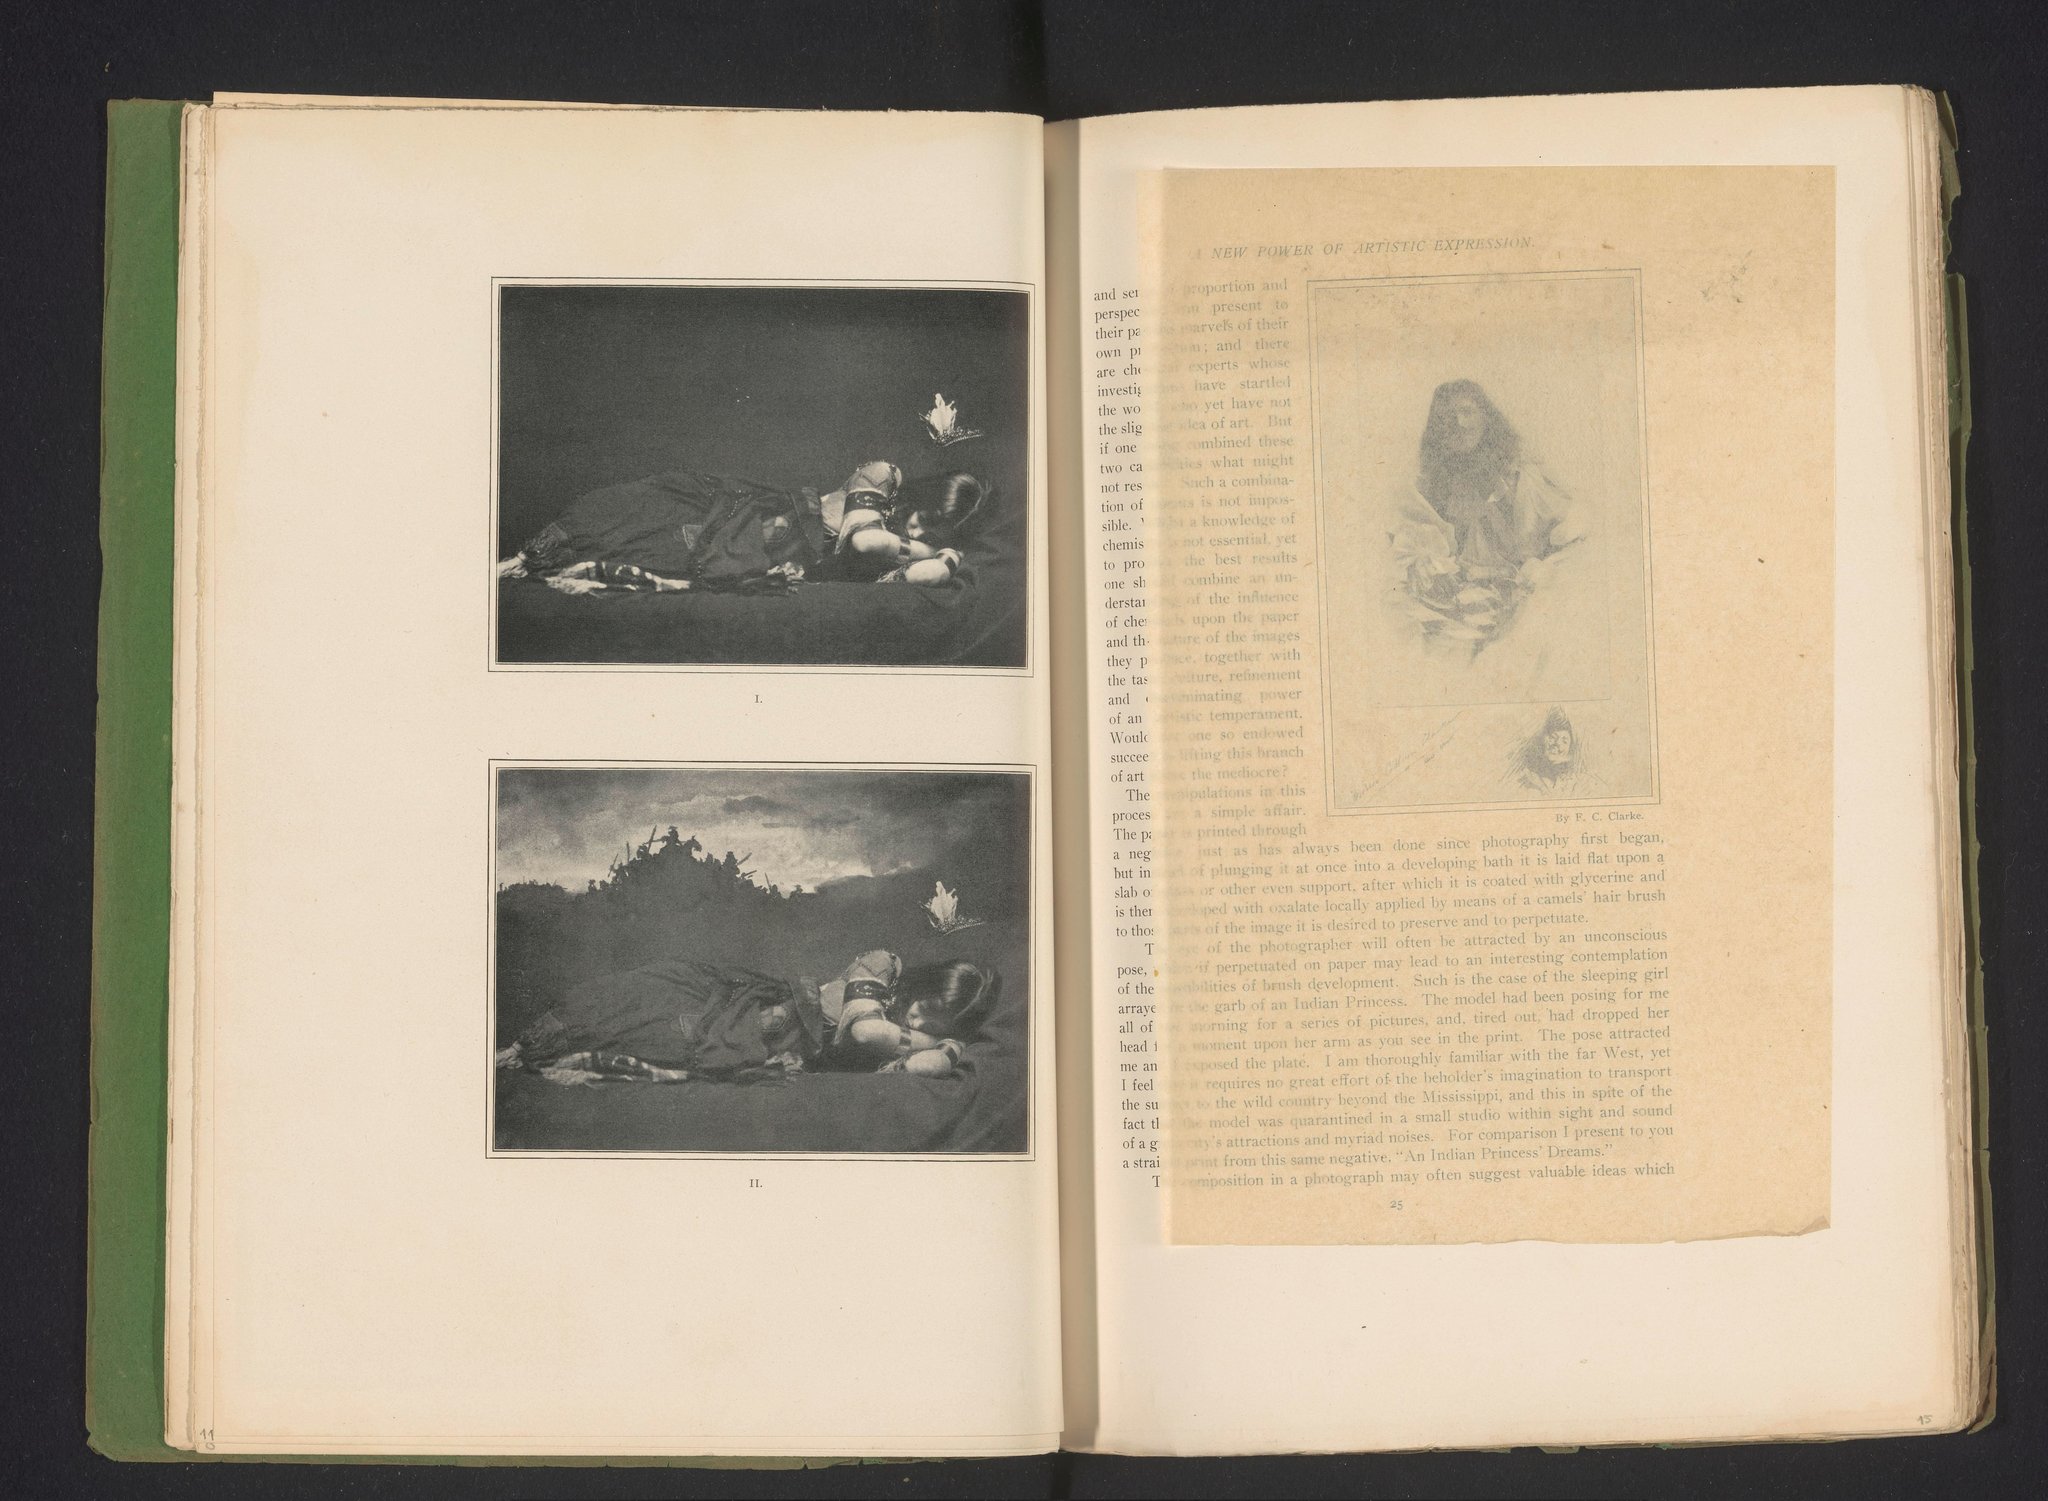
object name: page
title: II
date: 1896-1901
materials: paper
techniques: autotype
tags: adult woman, lying on one side, stretched out